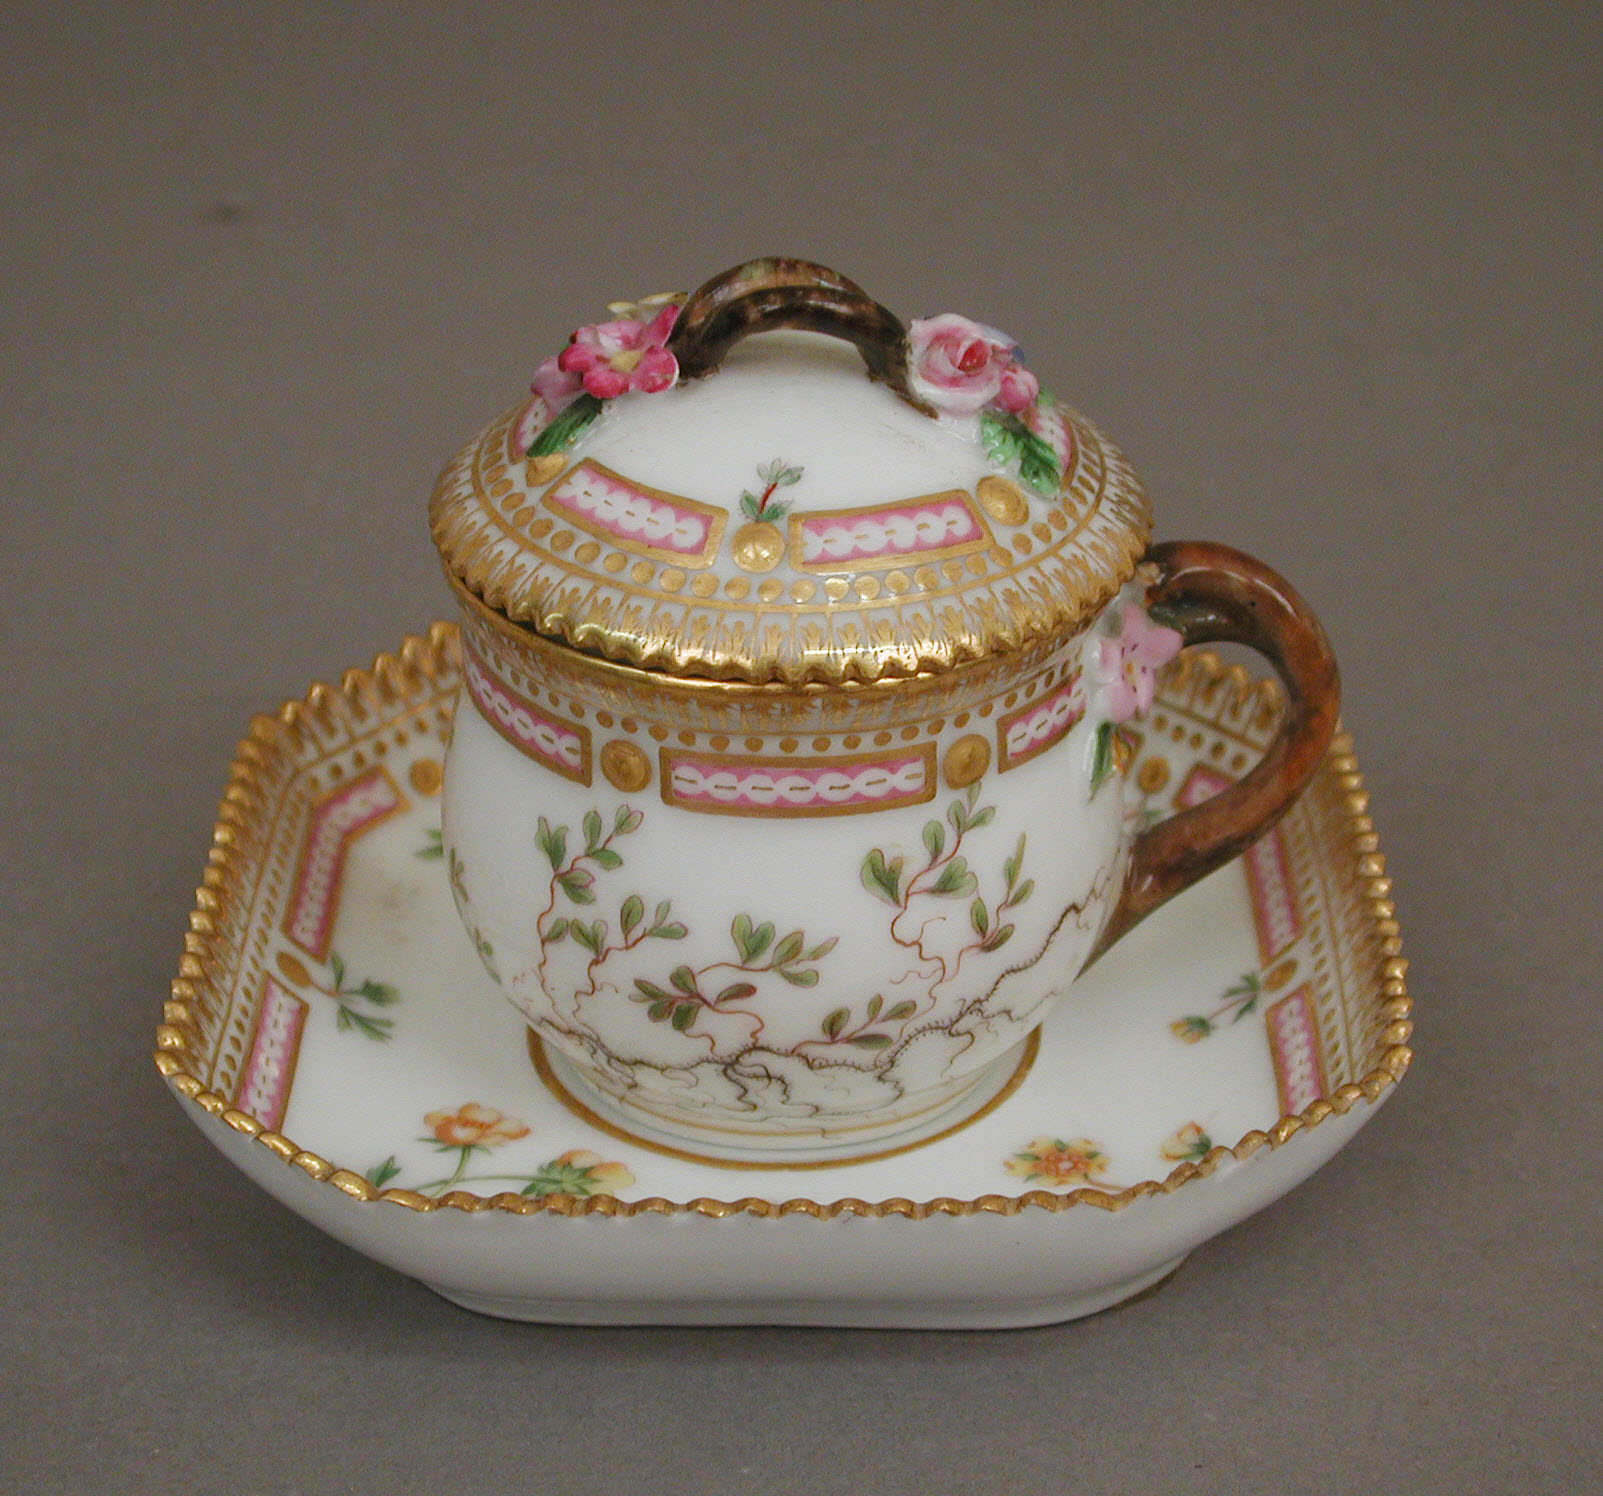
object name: custard cup with cover and tray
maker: royal porcelain manufactory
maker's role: factory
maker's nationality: danish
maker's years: 1775-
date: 1880-1890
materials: hard paste porcelain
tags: flowers